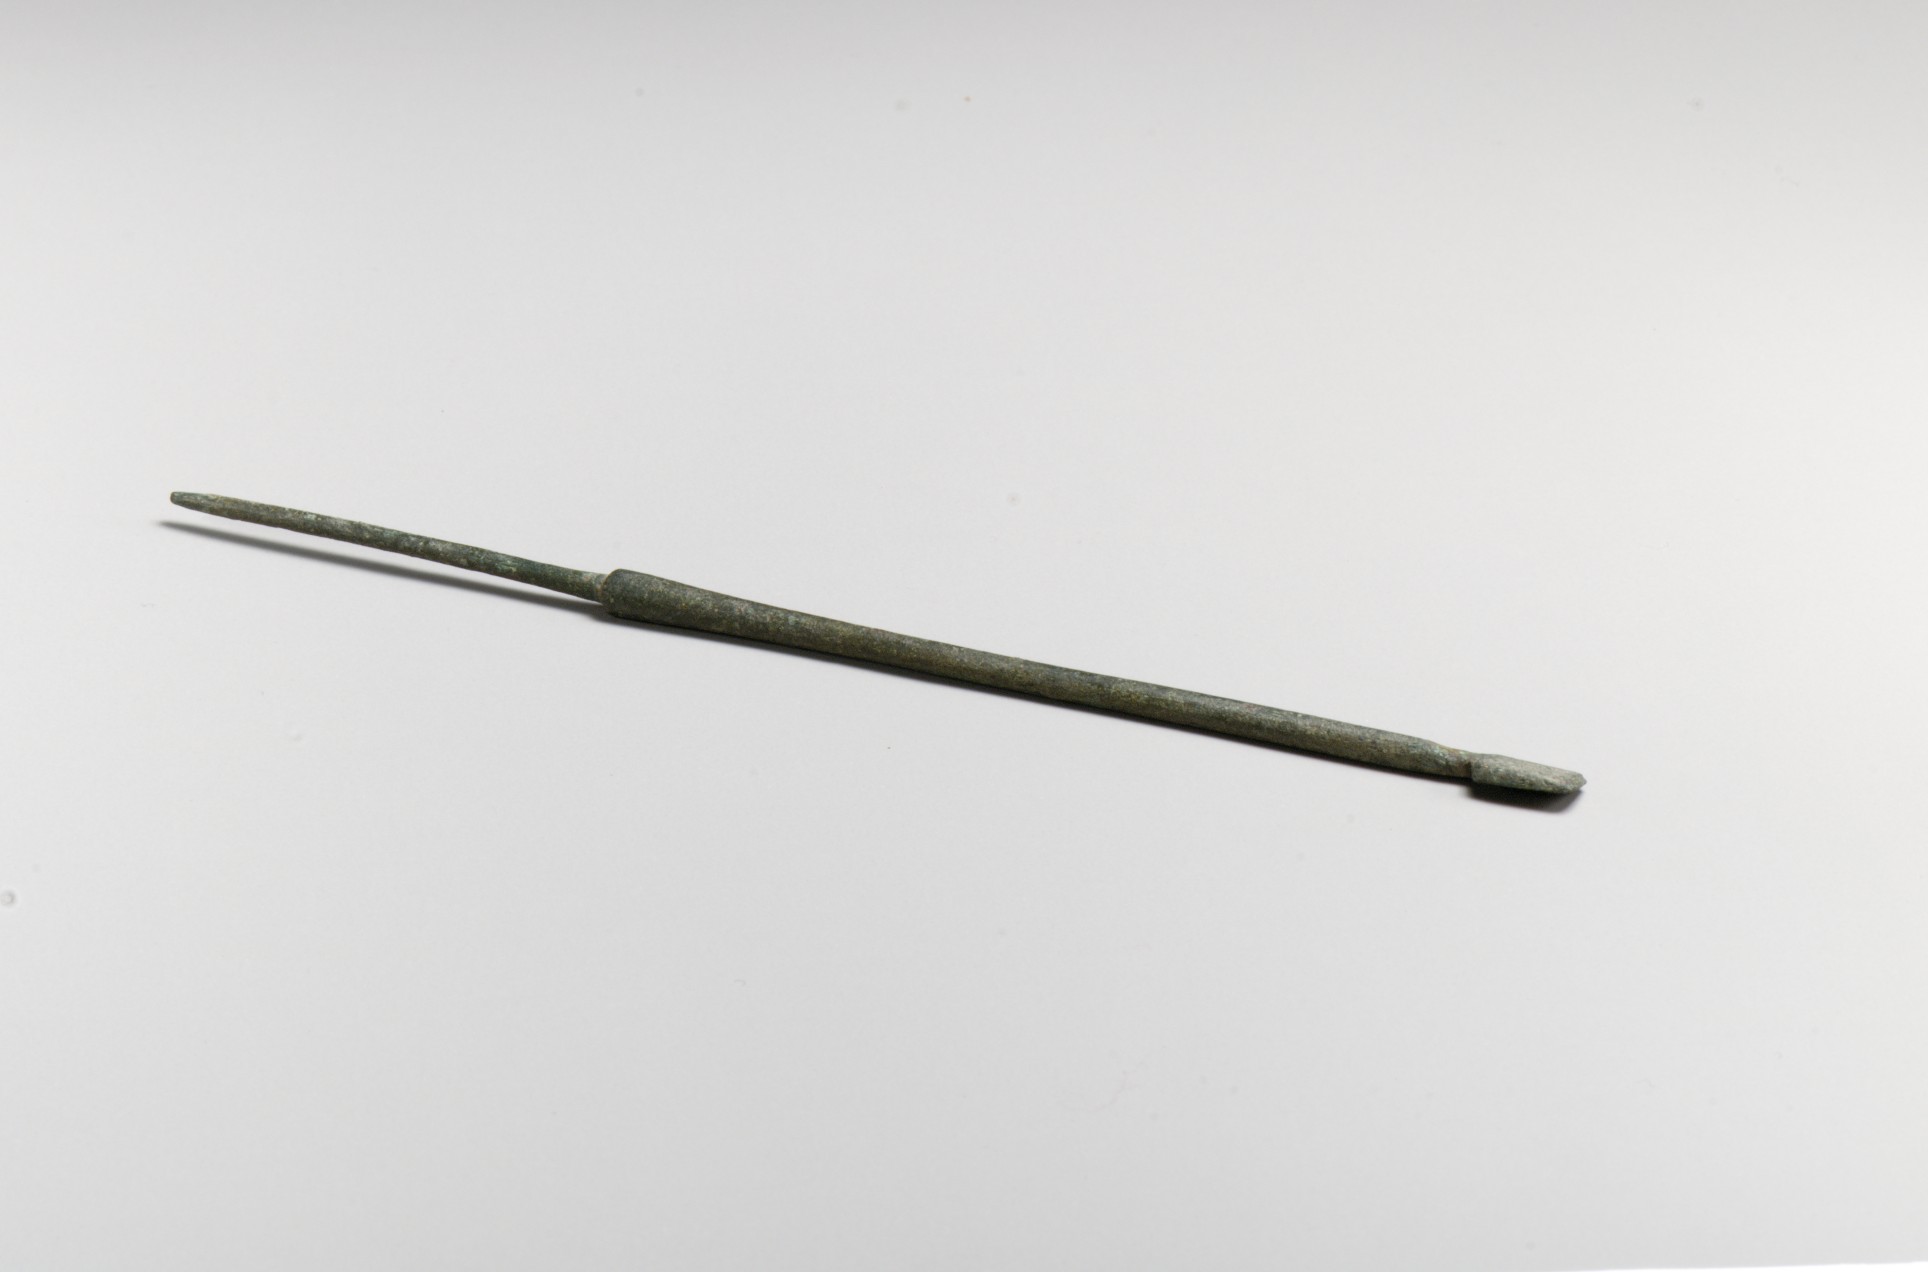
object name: stylus or tool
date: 7000 BCE-330 CE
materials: bronze